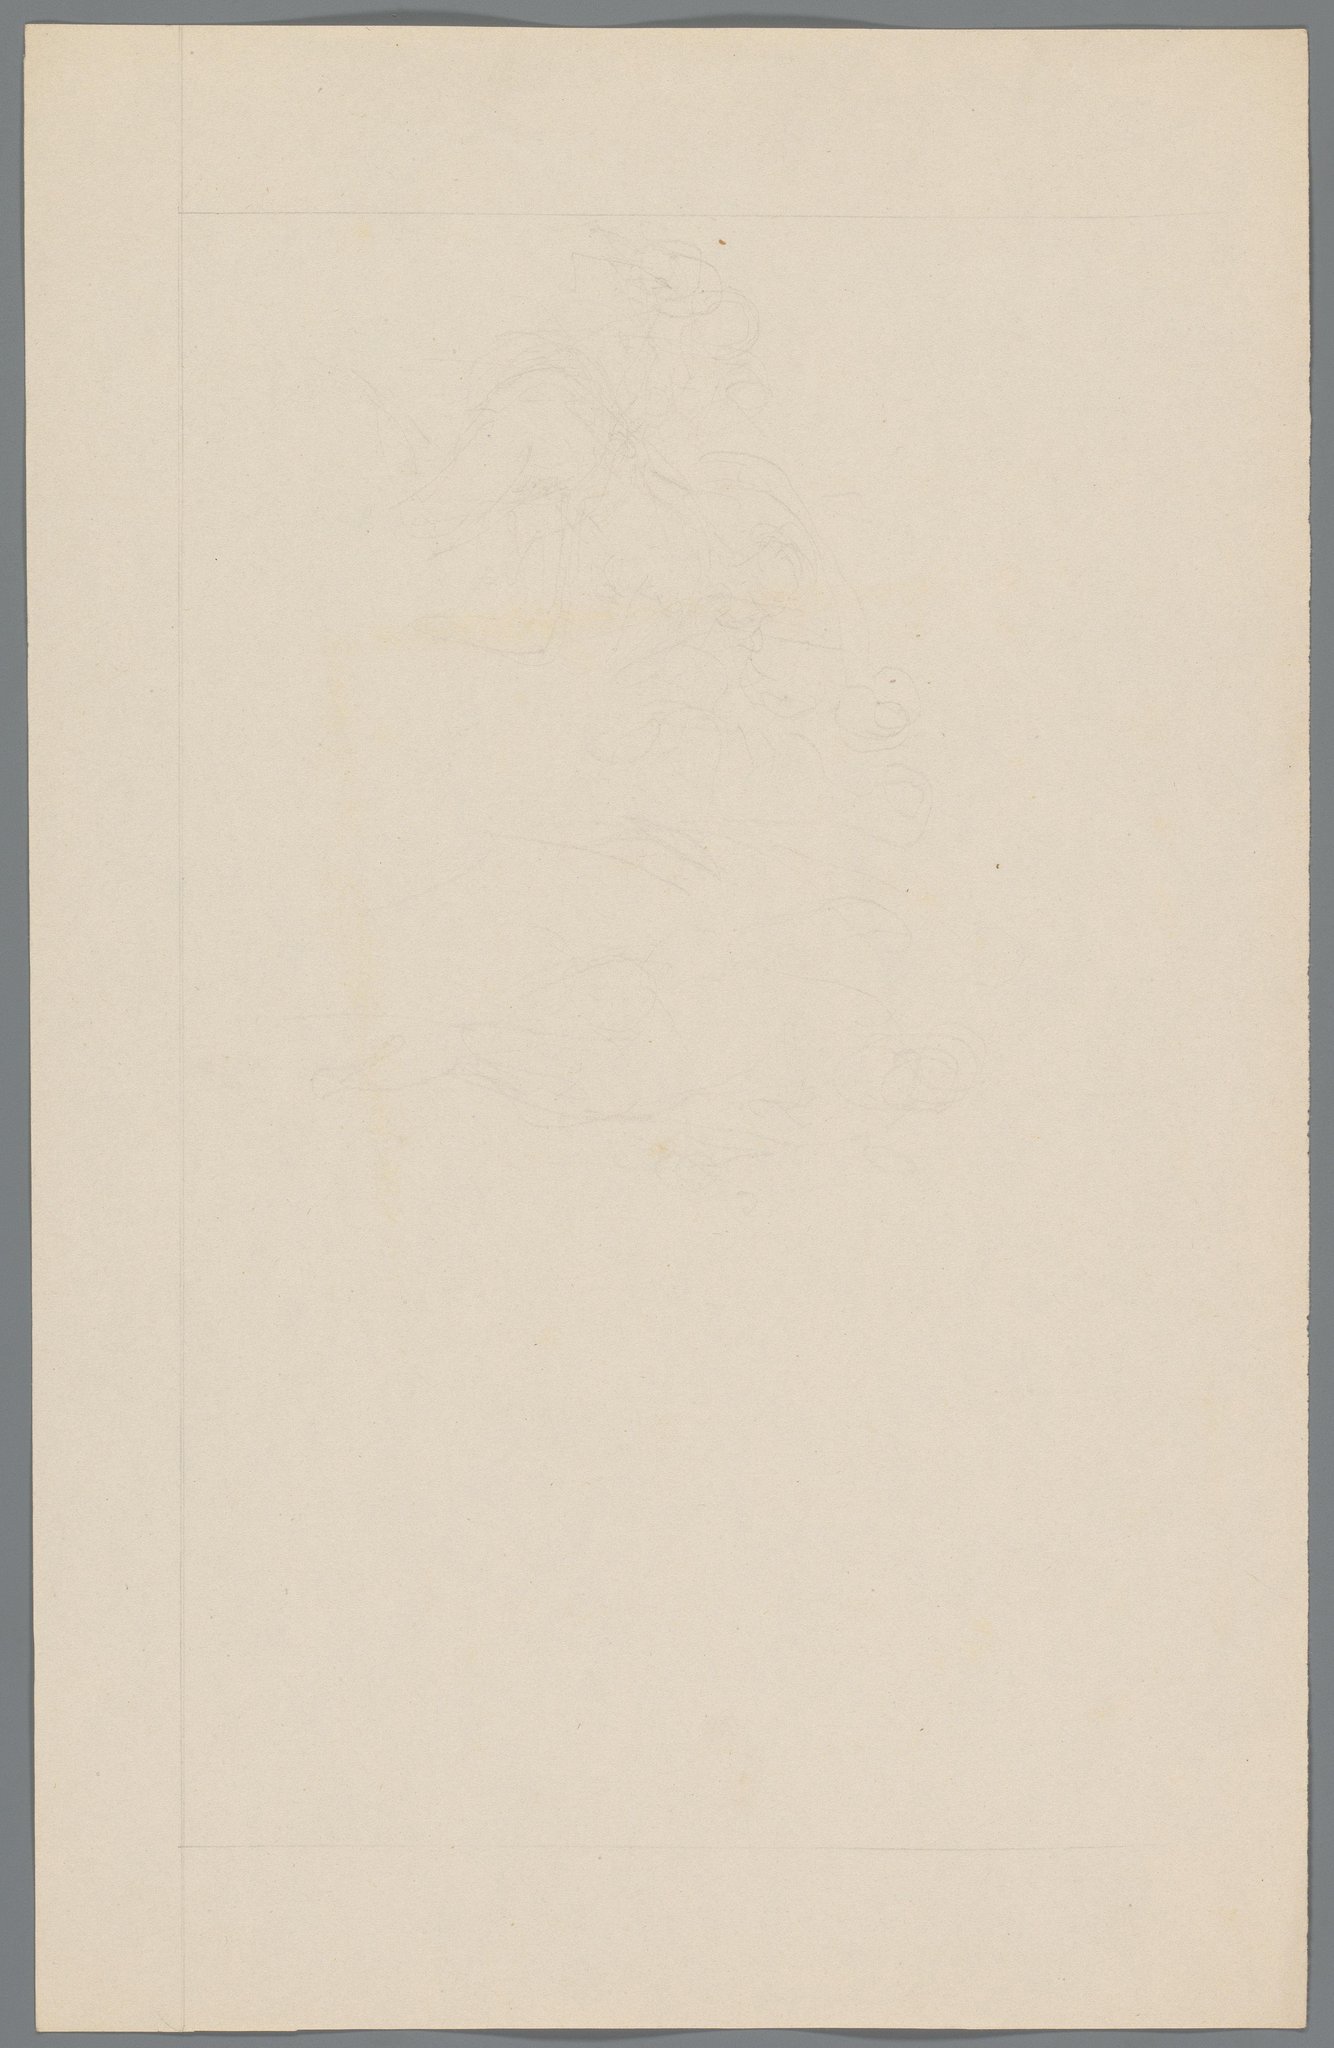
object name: drawing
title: Schets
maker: jacobus everhardus josephus van den berg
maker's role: draughtsman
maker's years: 1802-1861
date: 1812-1861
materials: paper, pencil